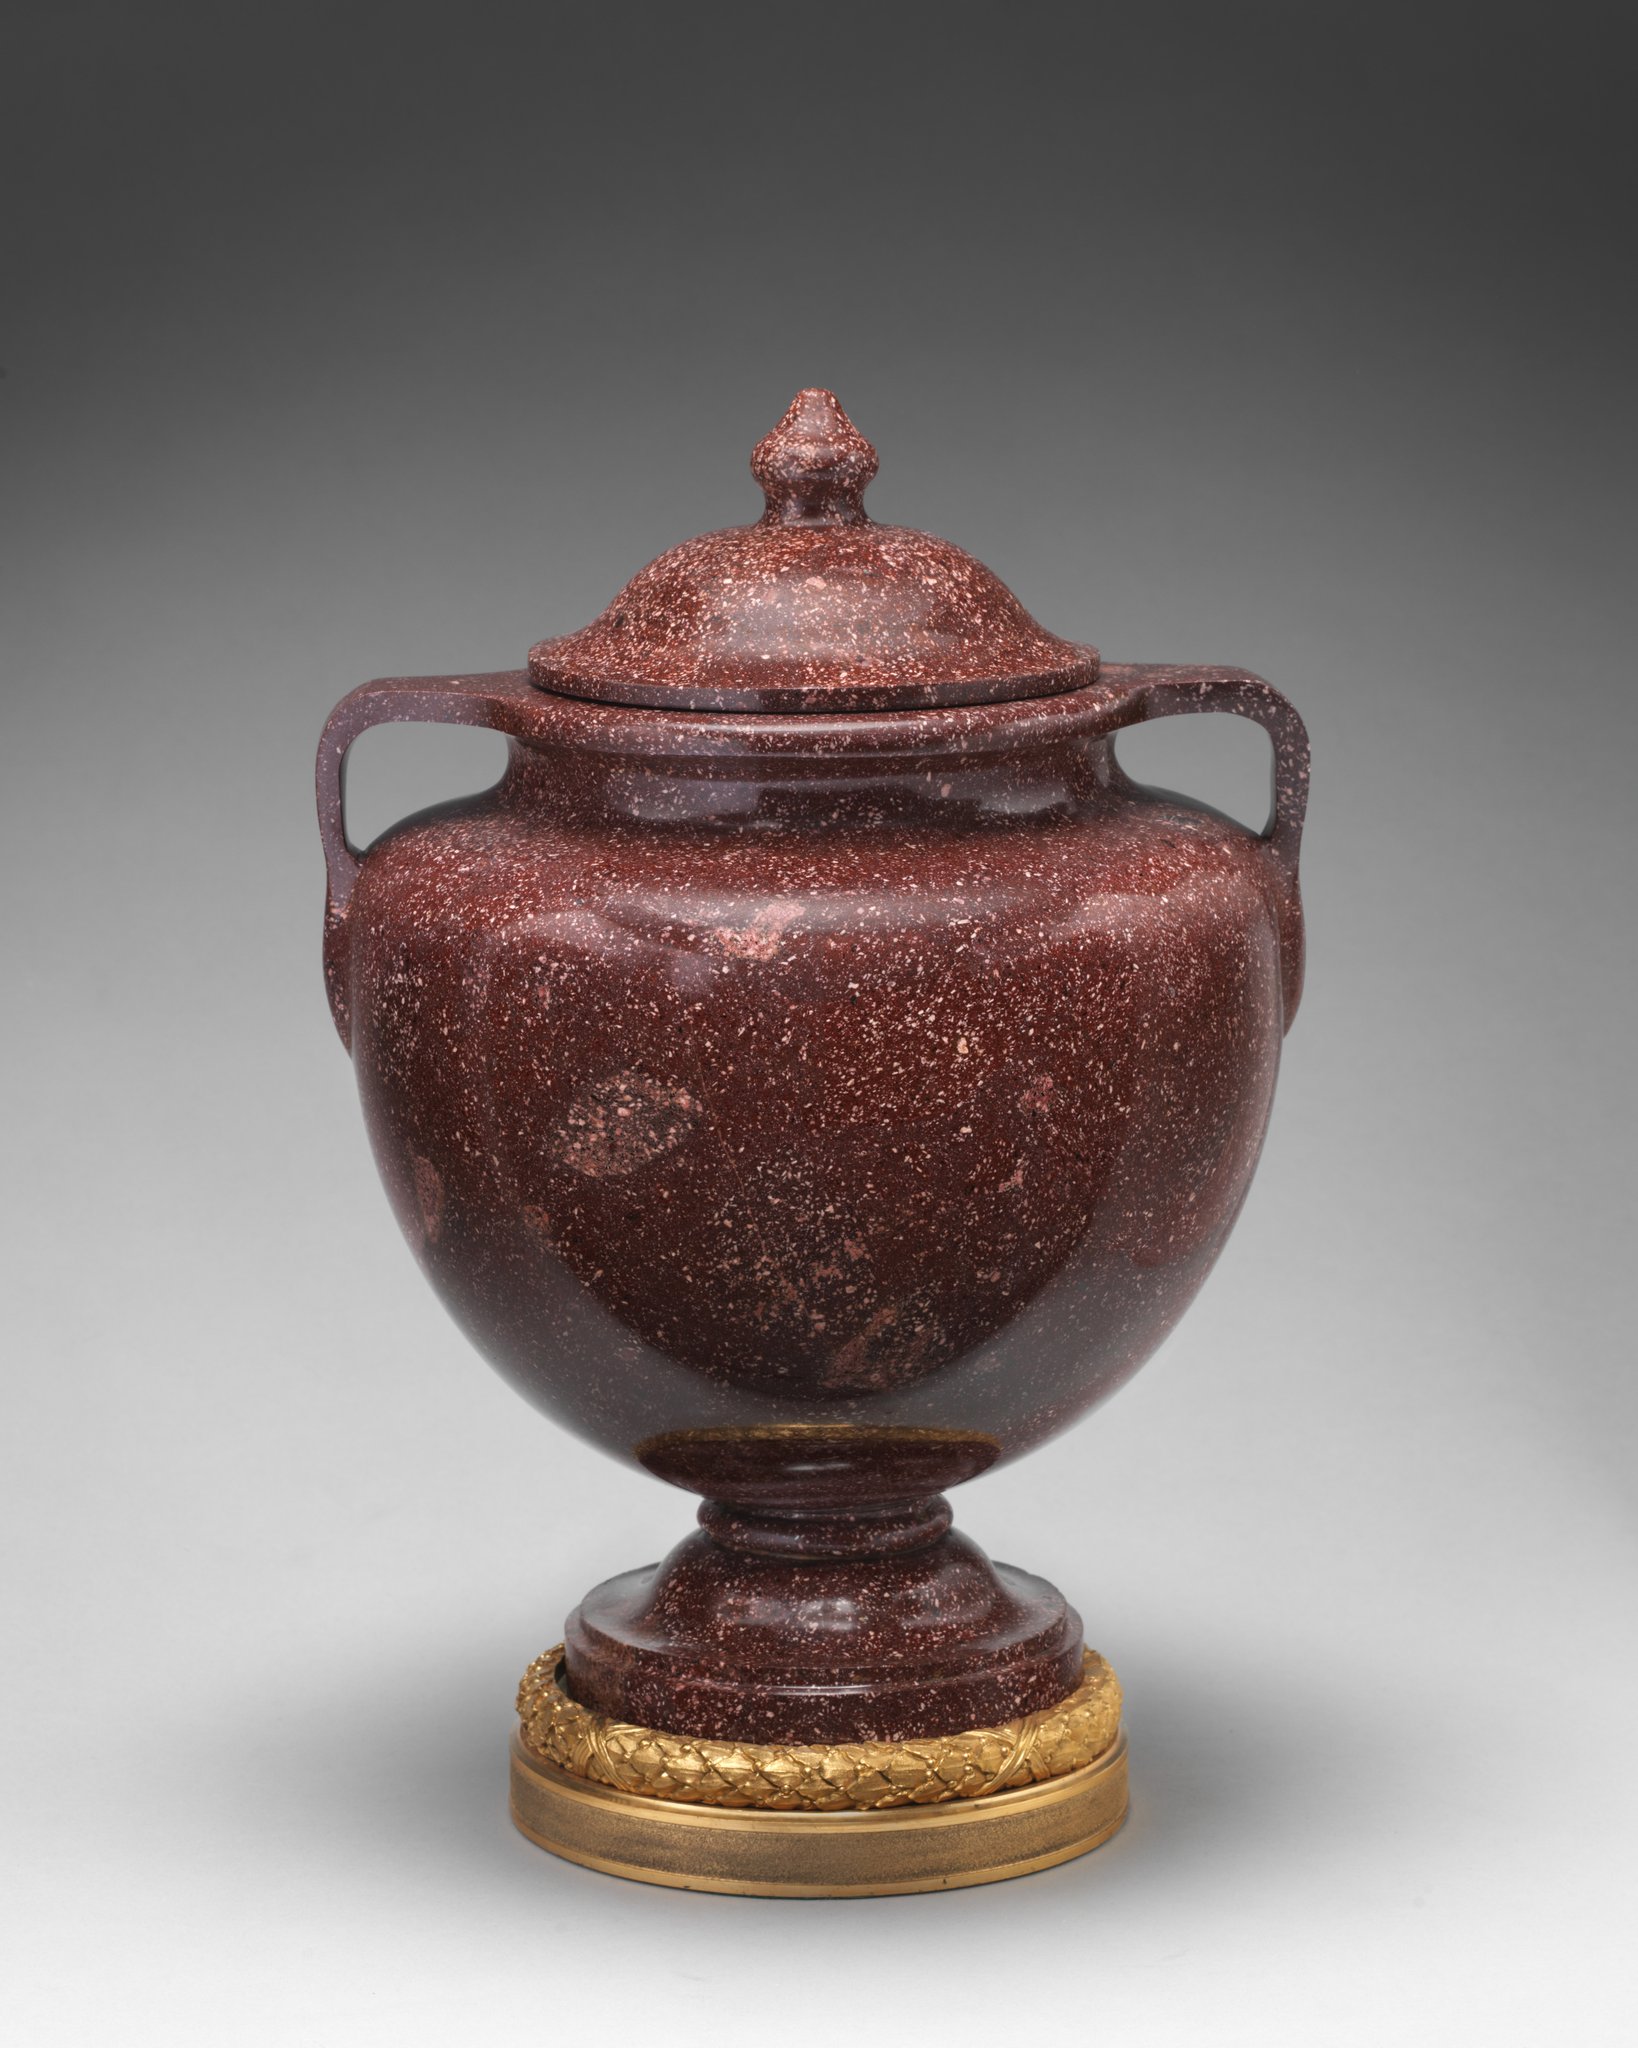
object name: urn with cover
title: Spherical body urn with cover (one of a pair)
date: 1770-1820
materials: gilt bronze